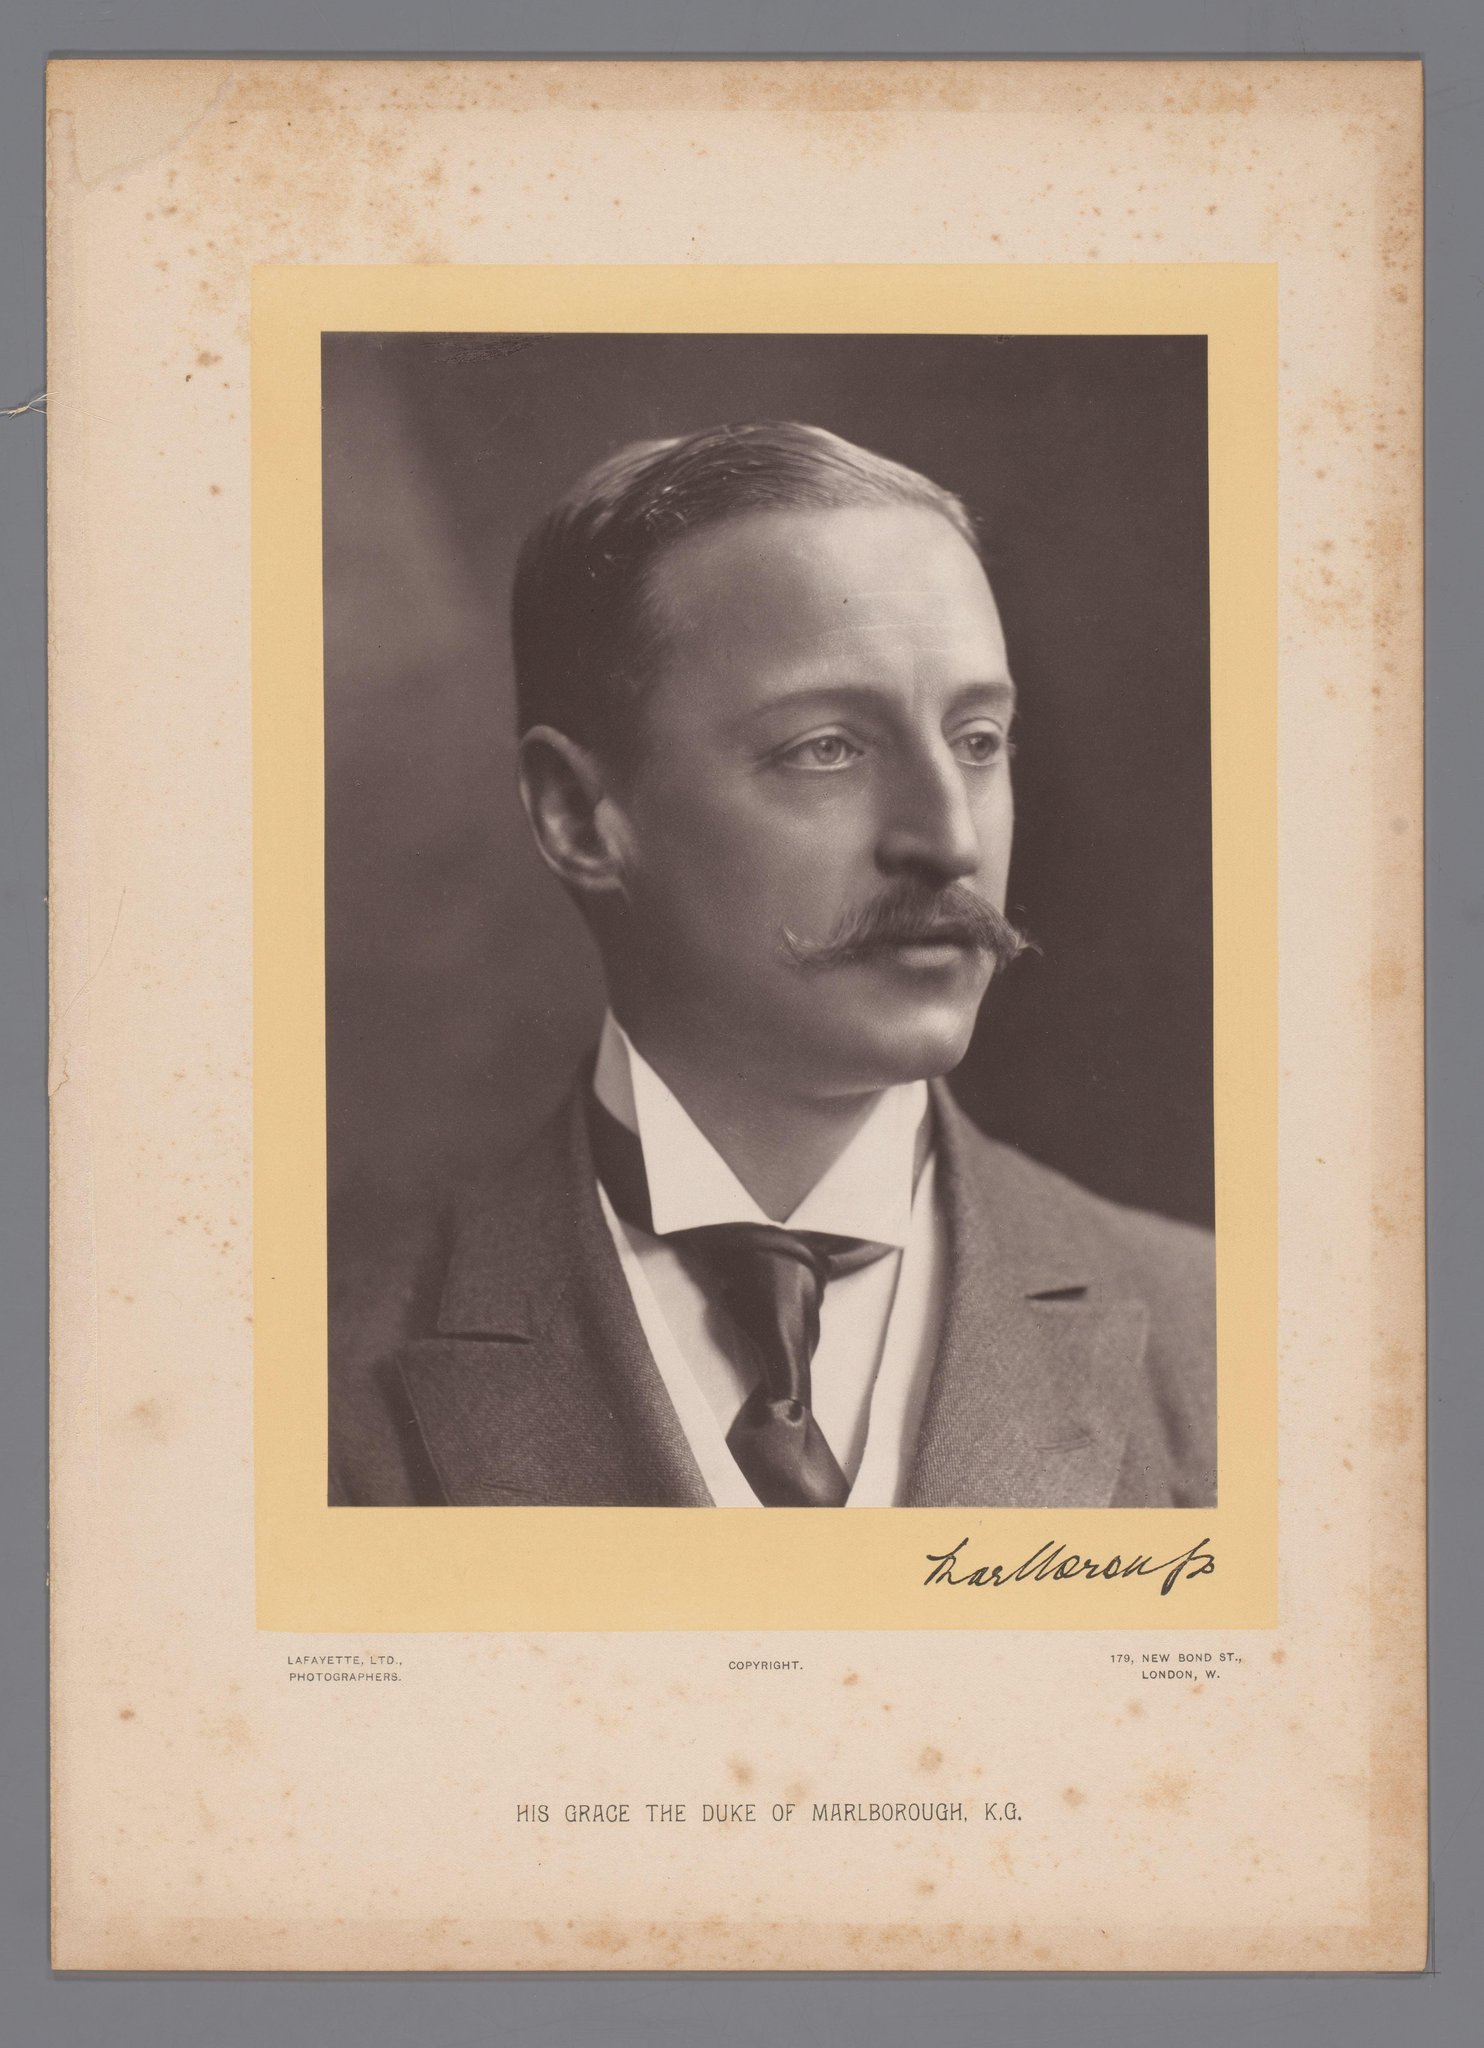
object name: photograph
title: Duke of Marlborough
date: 1890-1910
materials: cardboard, paper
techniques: carbon print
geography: london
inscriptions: caption: ‘His Grace The Duke of Marlborough, K.G.’, caption: ‘Marlborough’, caption: ‘Lafayette, LTD.,//Photographers//Copyright//179, New Bond St.,//London, W.’